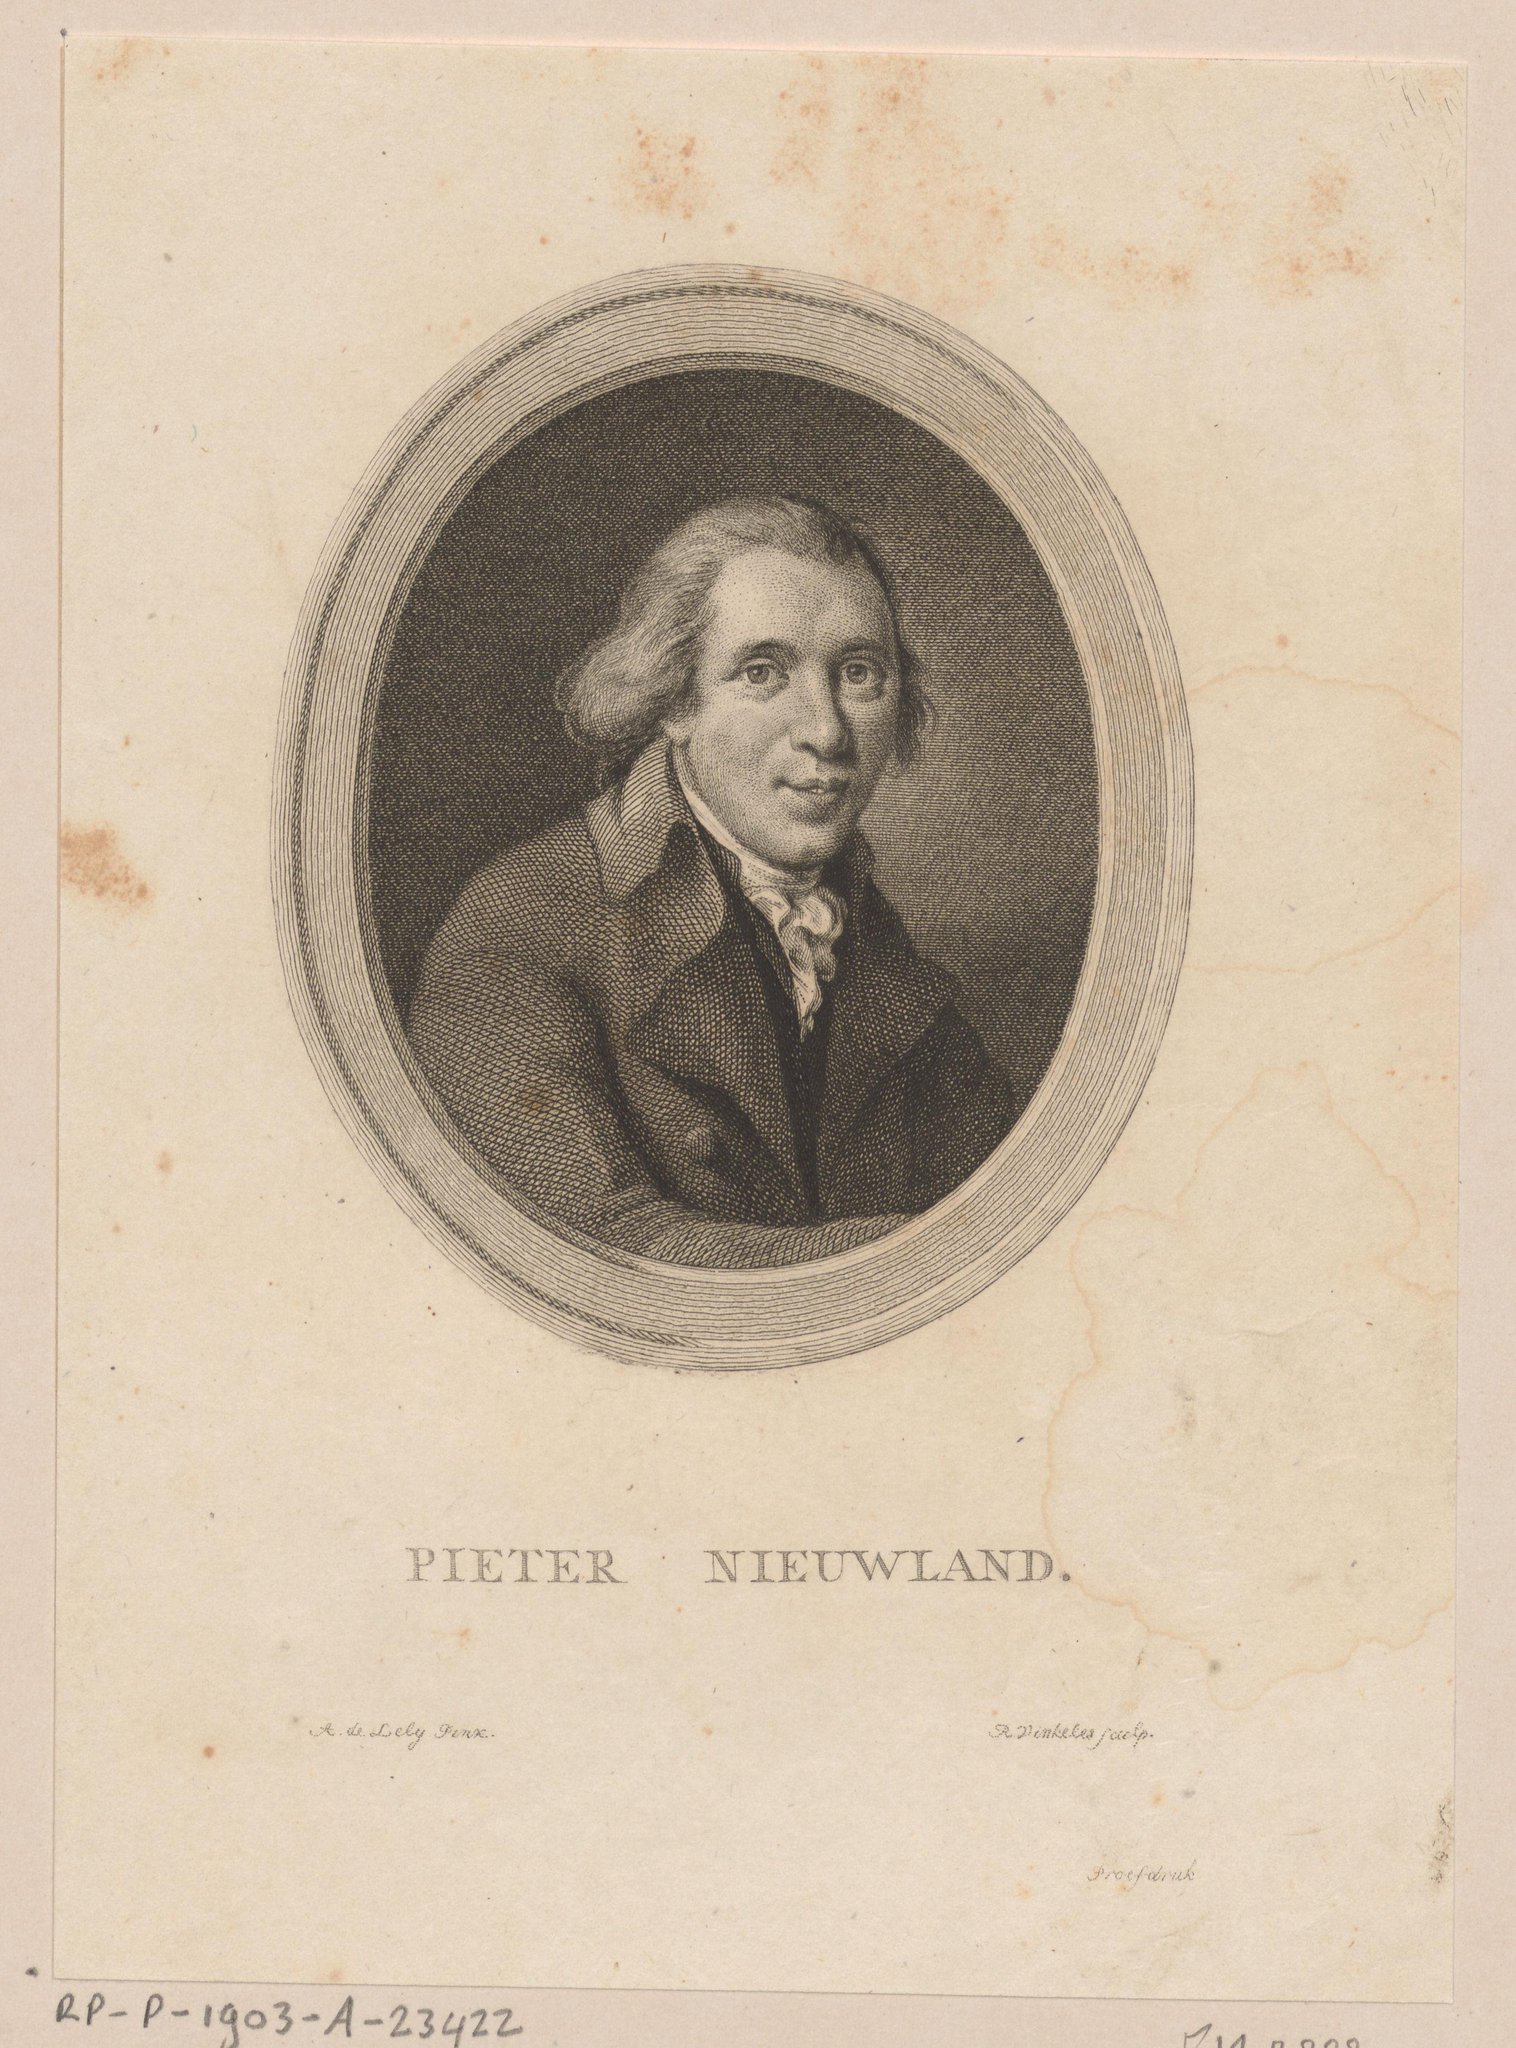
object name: print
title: Portret van Pieter Nieuwland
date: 1786-1809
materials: paper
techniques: etching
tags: historical persons, professor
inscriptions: collector's mark: Lugt 2228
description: Latere staat van prent gebruikt in: Wagenaar, Jan. Vaderlandsche historie, (...) ten vervolge van Wagenaars Vaderlandsche historie. 43 dln. Amsterdam: Johannes Allart, 1786-1809.